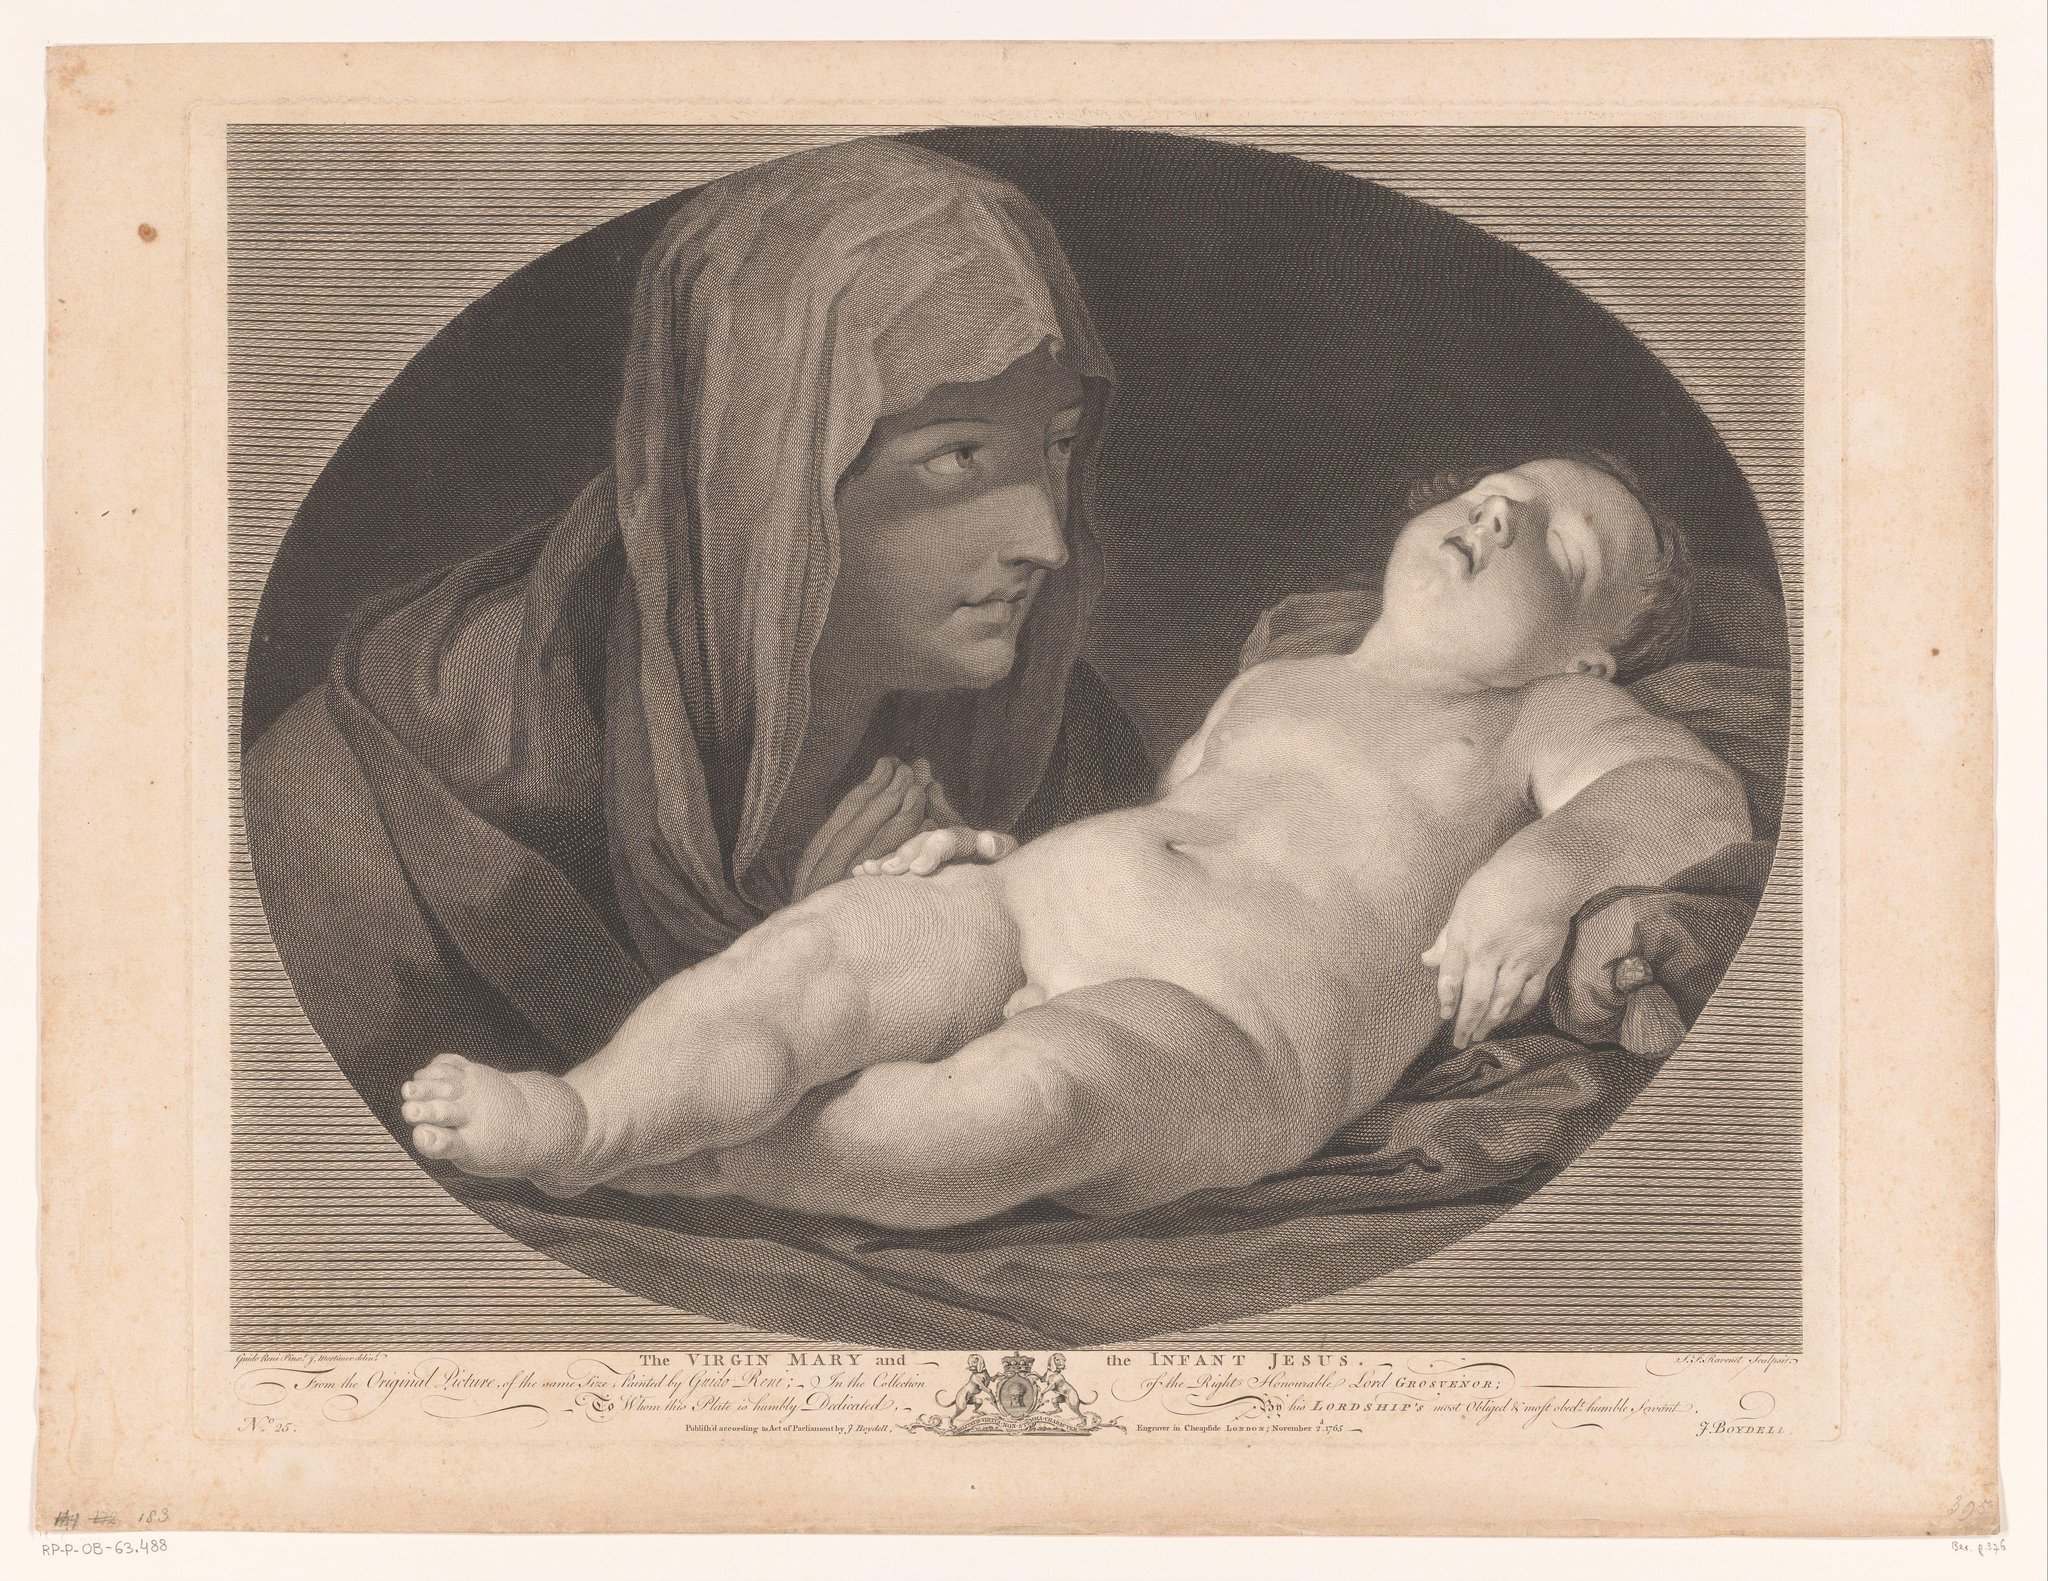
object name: print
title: The virgin Mary and the infant Jesus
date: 1765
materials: paper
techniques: engraving, etching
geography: london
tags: christ-child sleeping ~ madonna-representations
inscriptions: collector's mark: Lugt 240